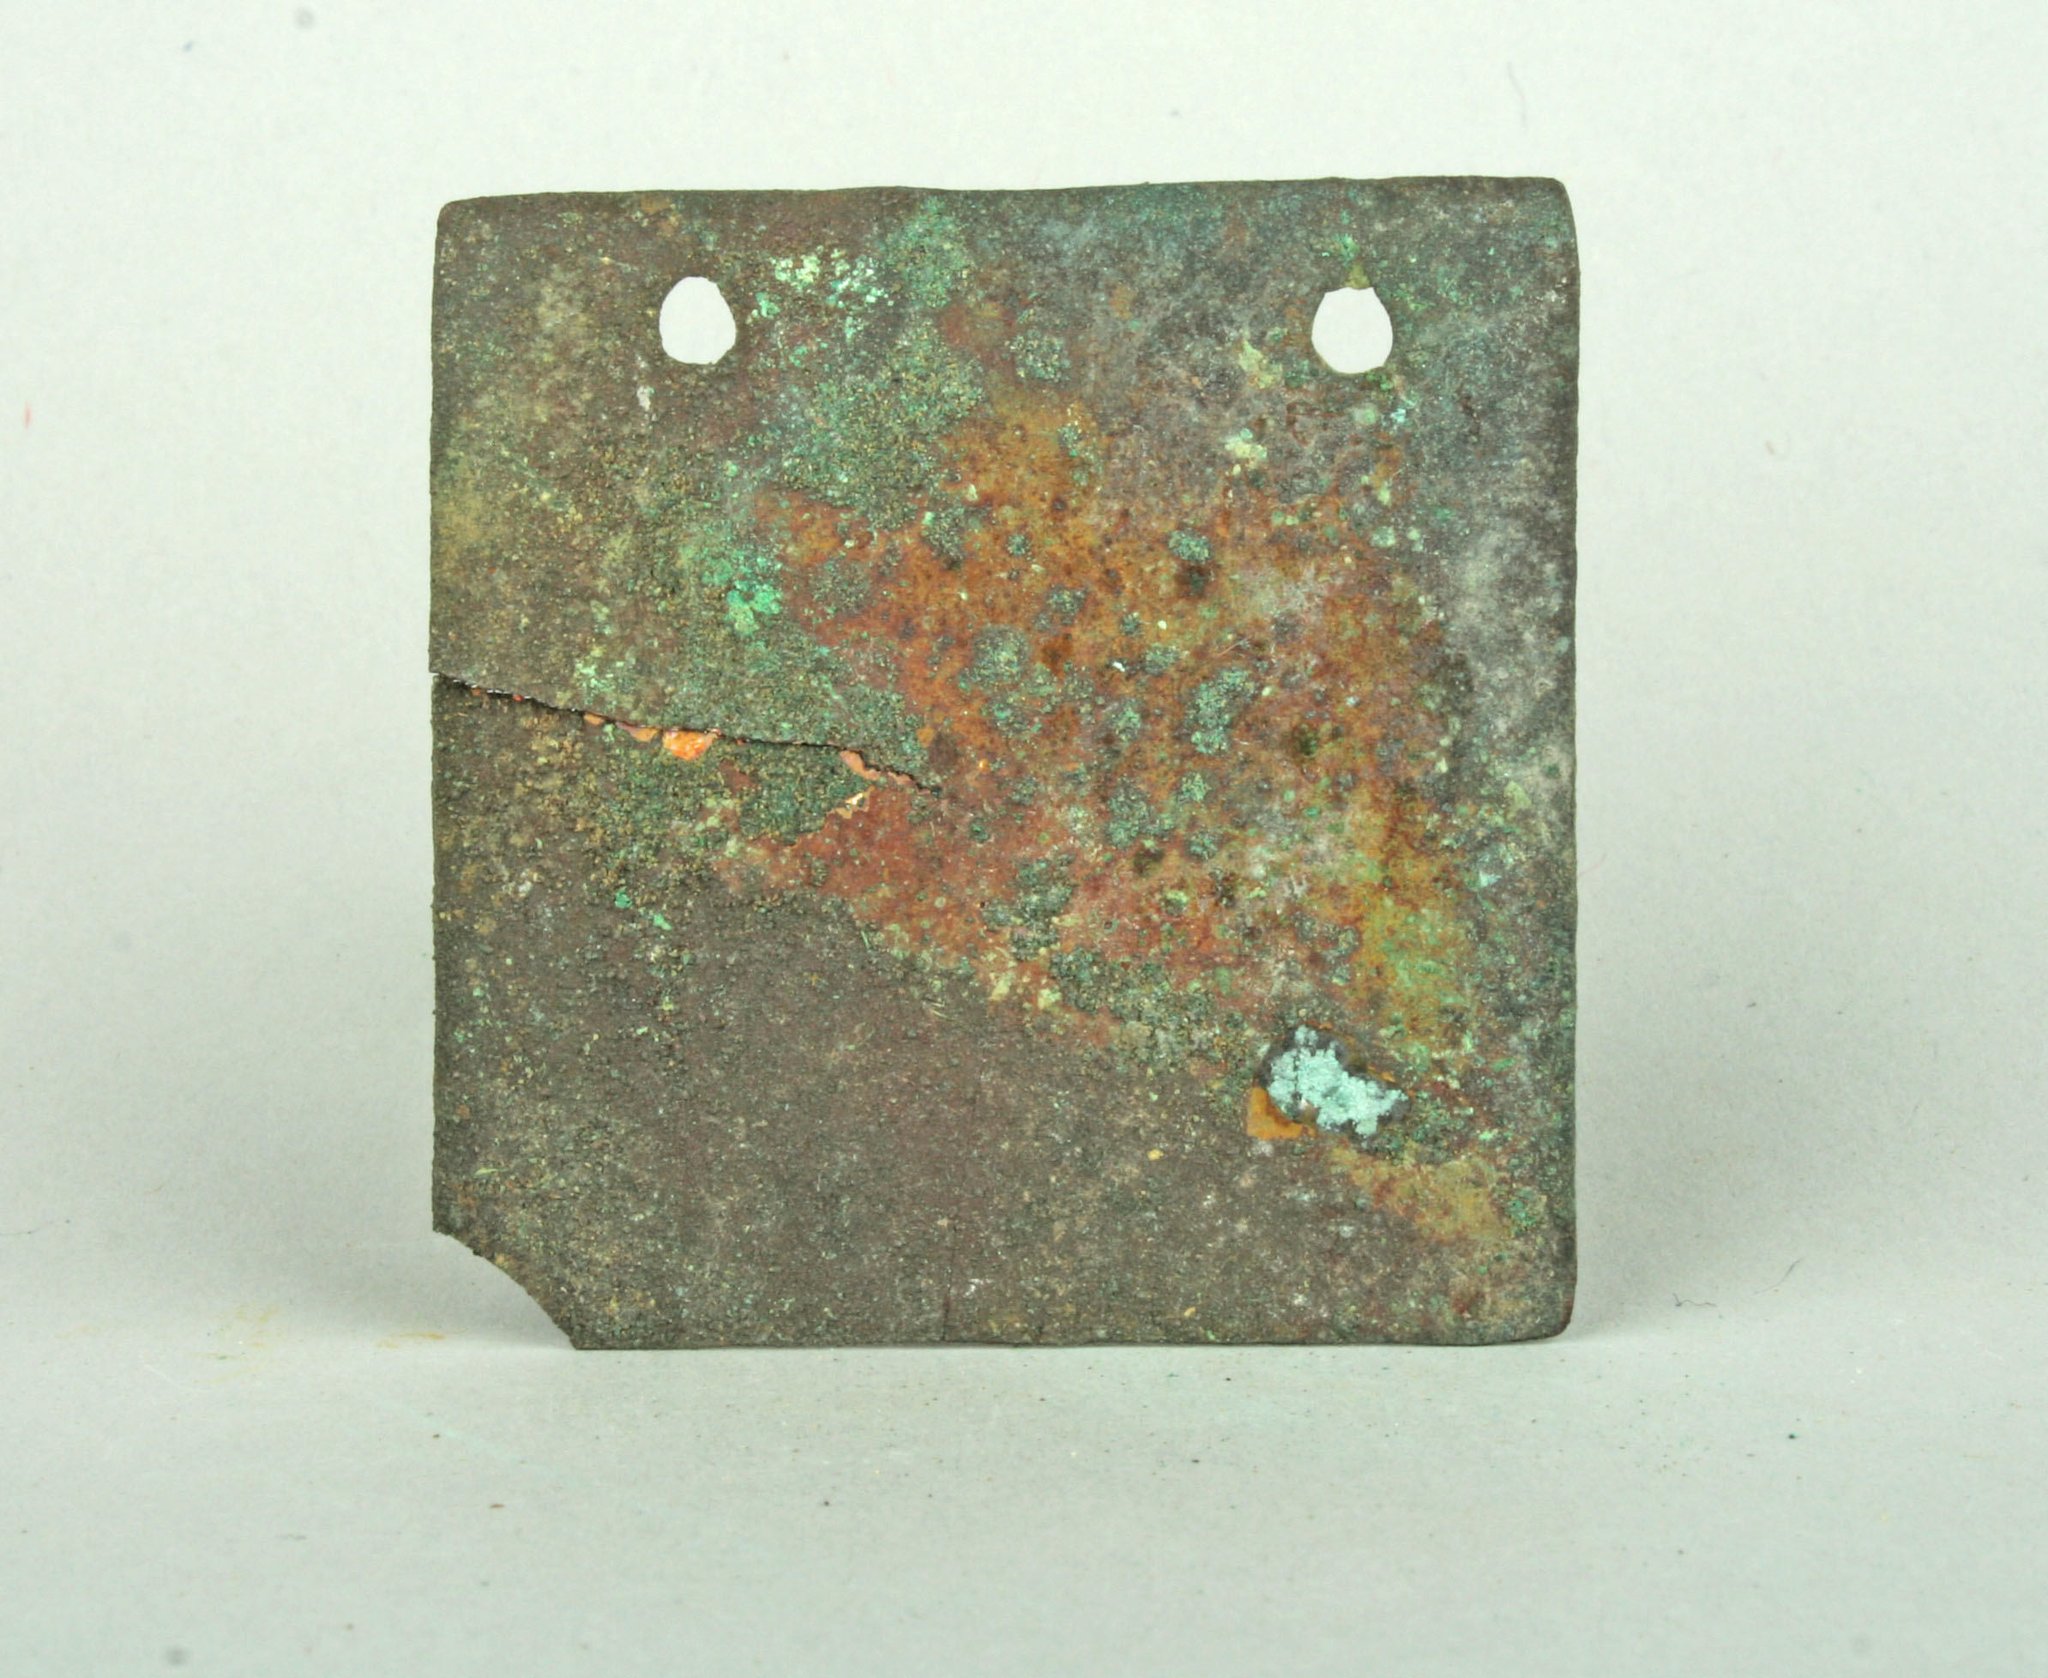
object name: plaque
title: Square Plaque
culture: vicús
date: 300 BCE-200 CE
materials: copper, gilt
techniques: hammering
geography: peru